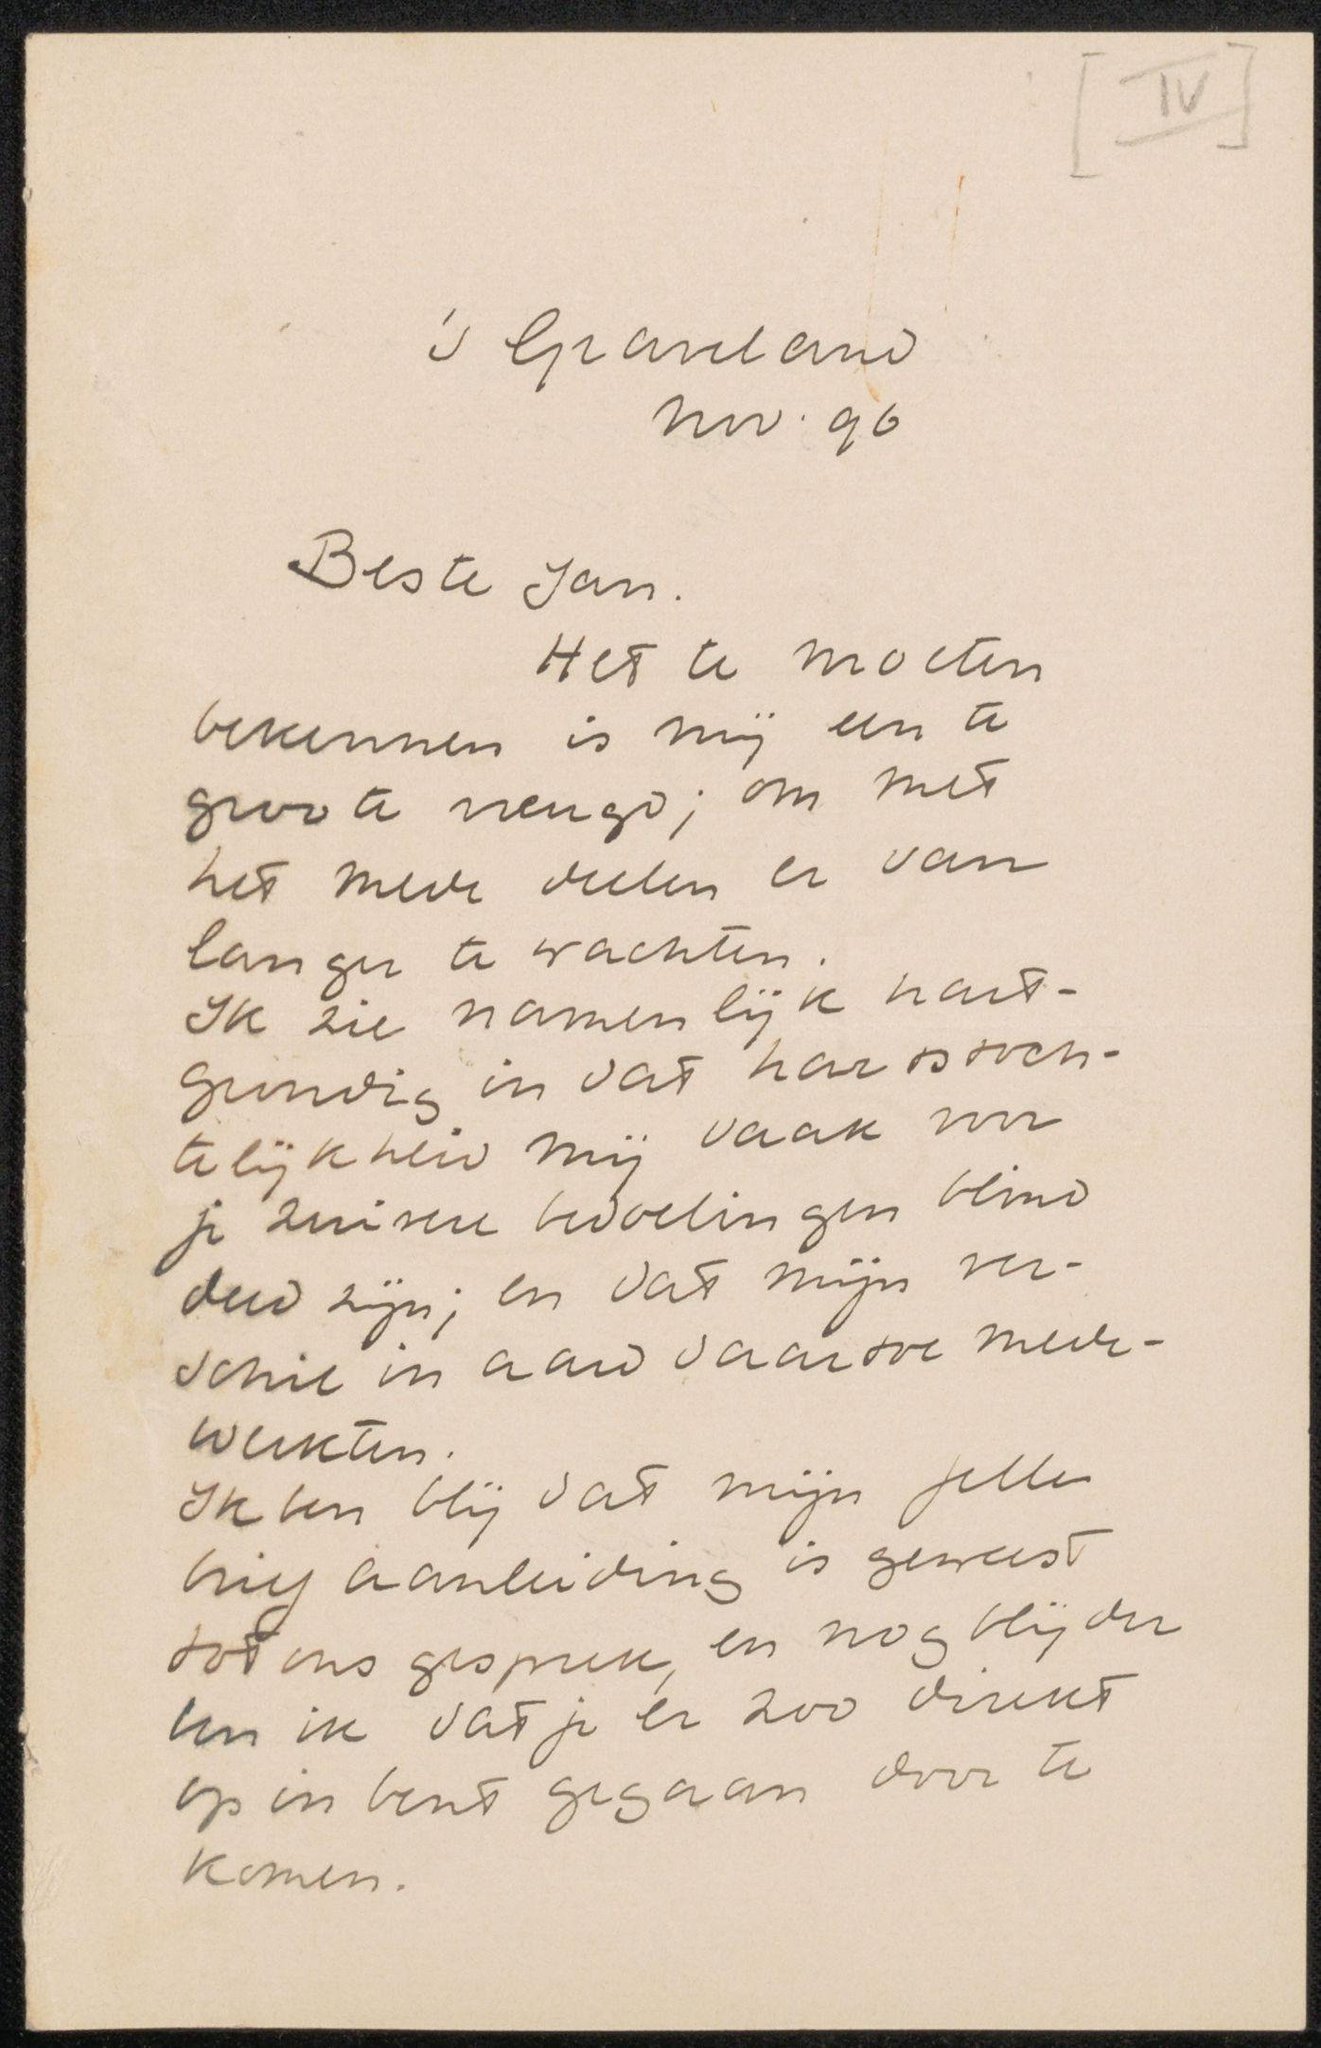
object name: letter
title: Brief aan Jan Veth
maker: richard nicolaüs roland holst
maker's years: 1868-1938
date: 1811-1896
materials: ink, paper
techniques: pen, writing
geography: s-graveland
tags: dordrecht, amsterdam, painter, print maker, draughtsman, designer, jan veth, passions, emotions, affections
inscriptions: collector's mark: ‘RPK’, watermark